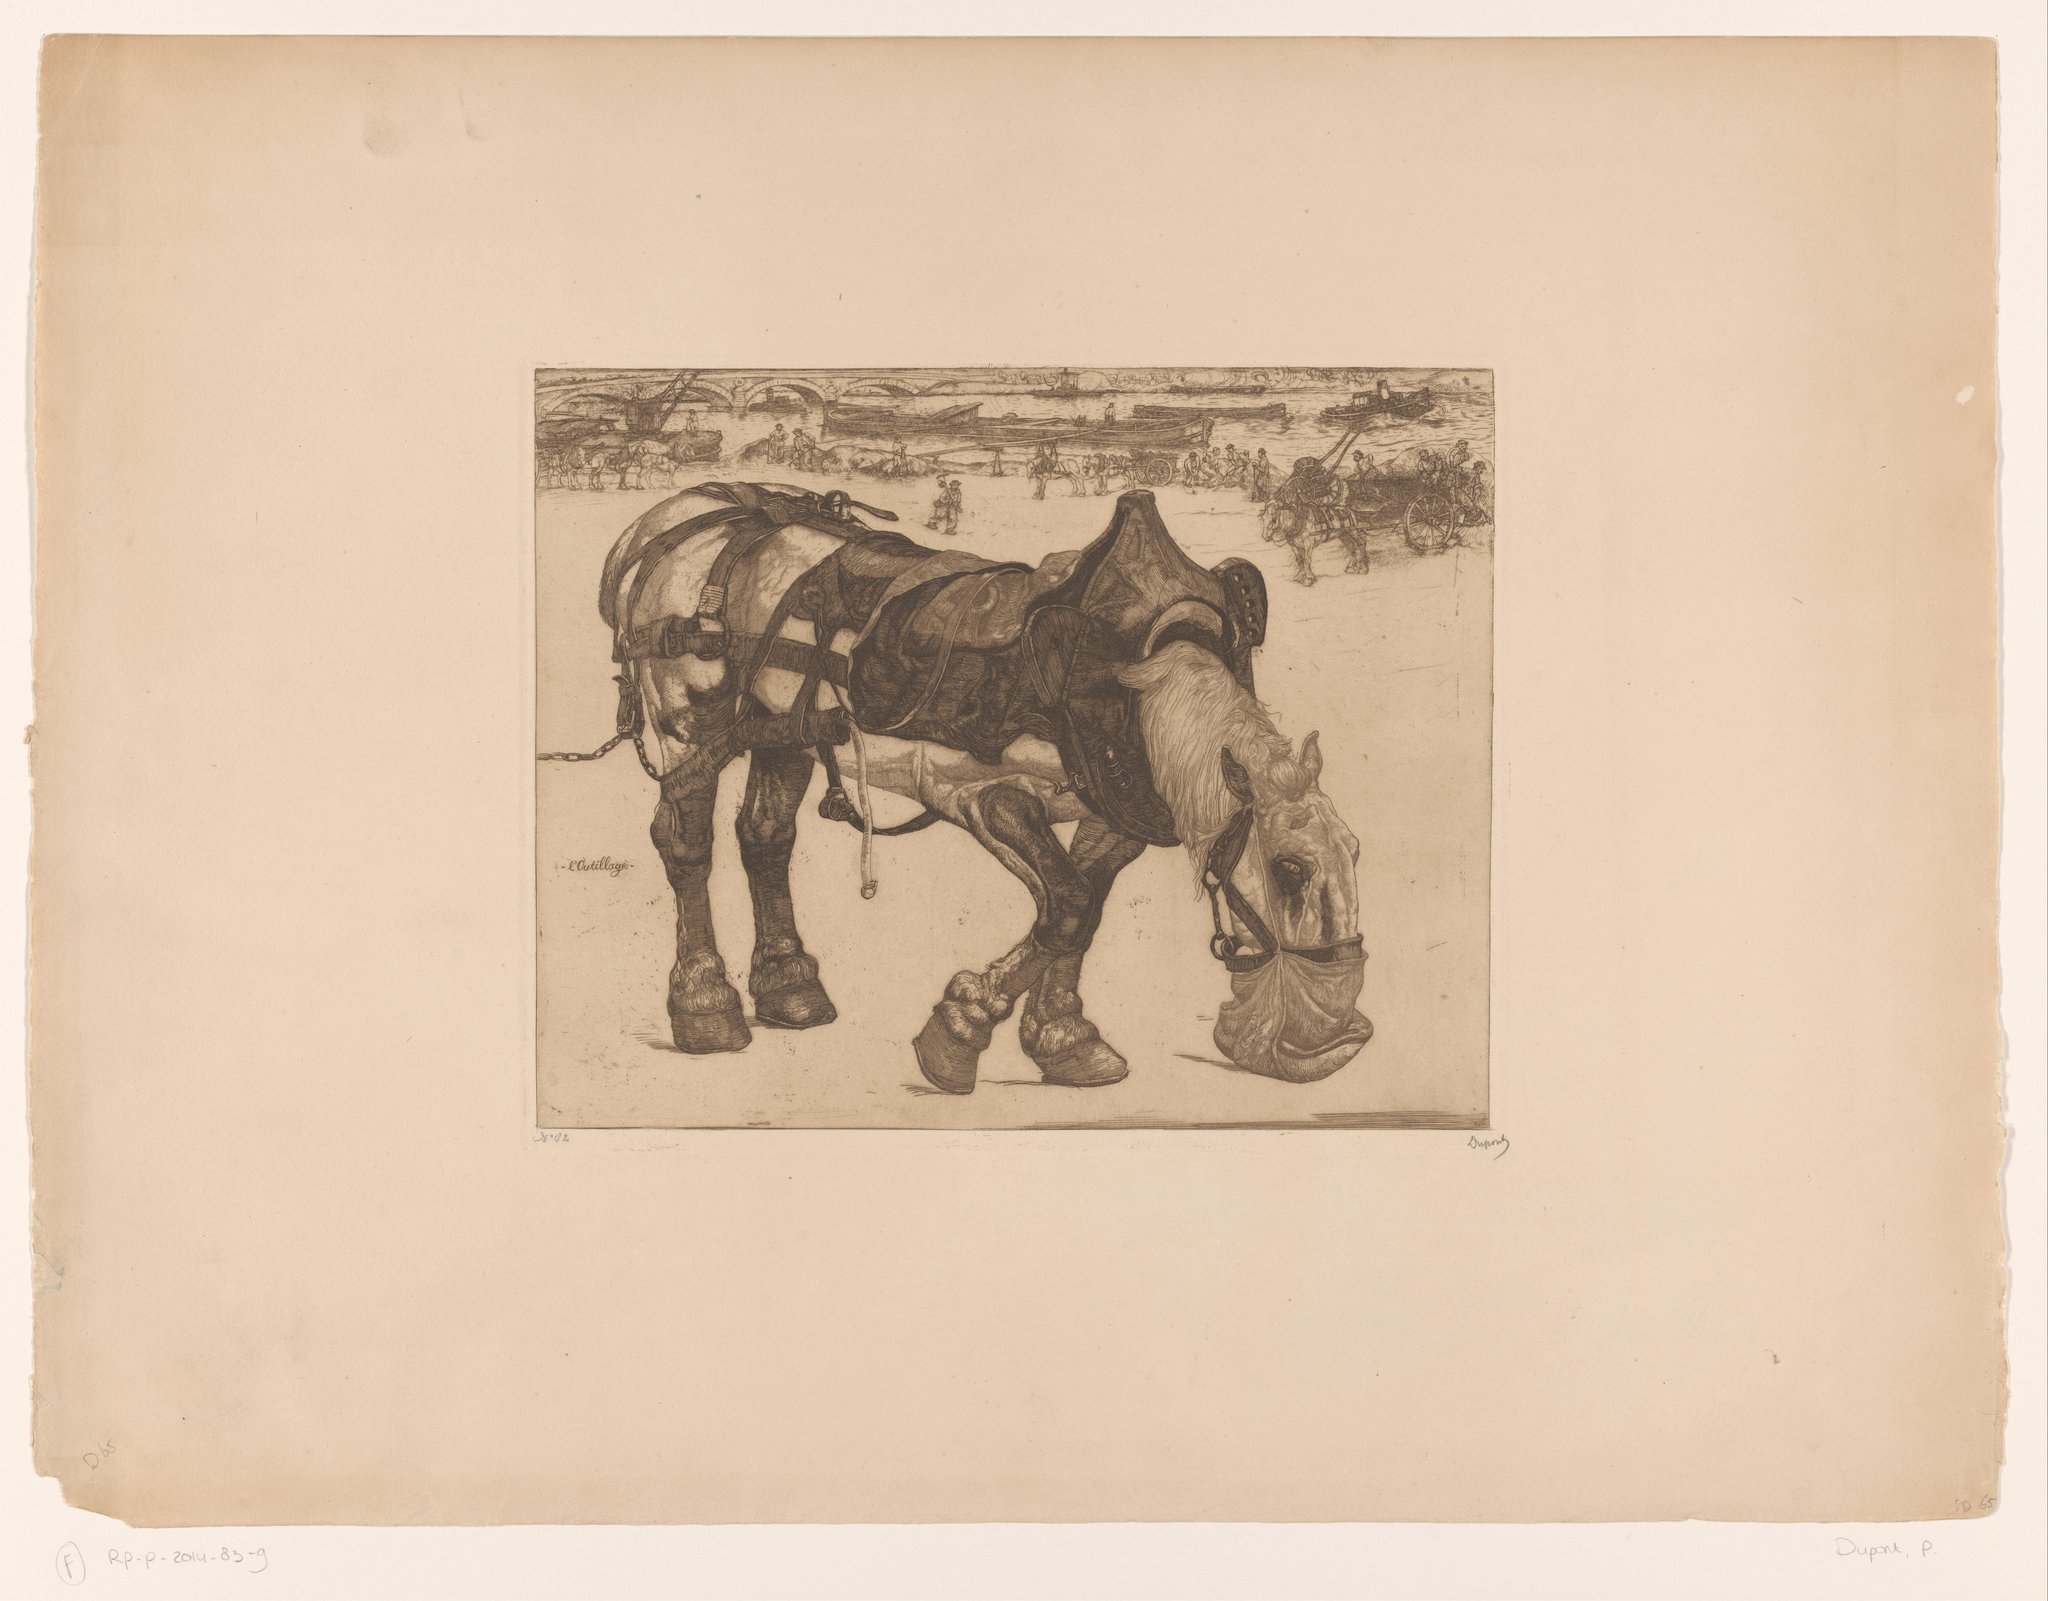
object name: print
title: Etend ploegpaard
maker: pieter dupont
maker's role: draughtsman, print maker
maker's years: 1870-1911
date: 1898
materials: paper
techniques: etching, intaglio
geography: amsterdam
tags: horses and kindred animals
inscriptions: collector's mark: Lugt 2228